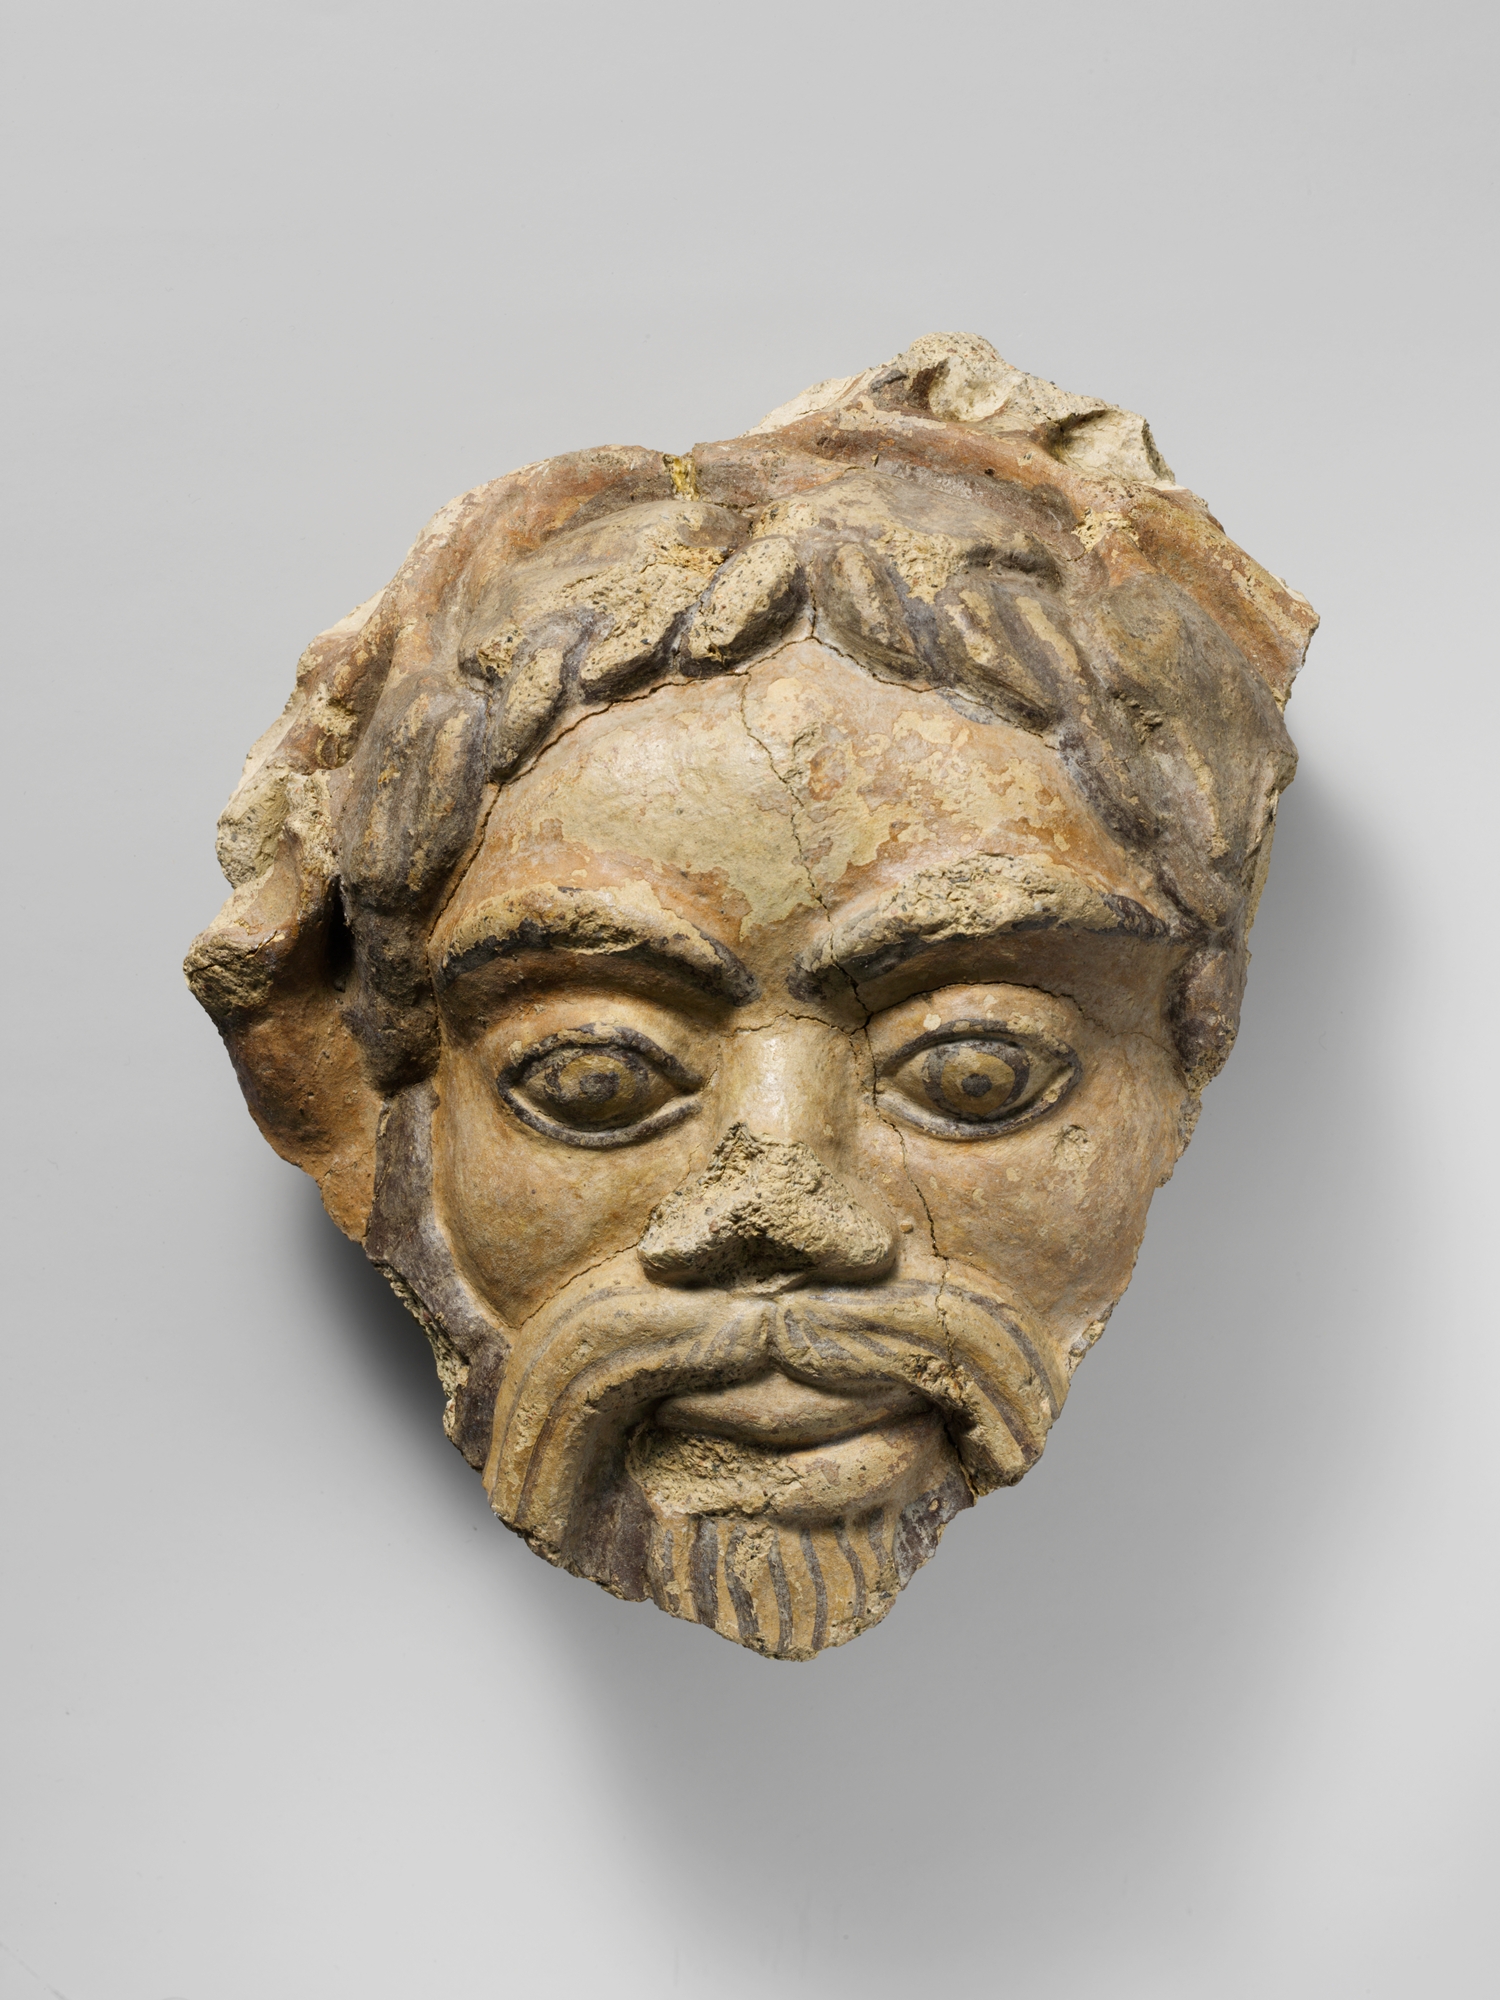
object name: antefix, head of satyr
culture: etruscan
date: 500-401 BCE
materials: terracotta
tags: heads,satyrs